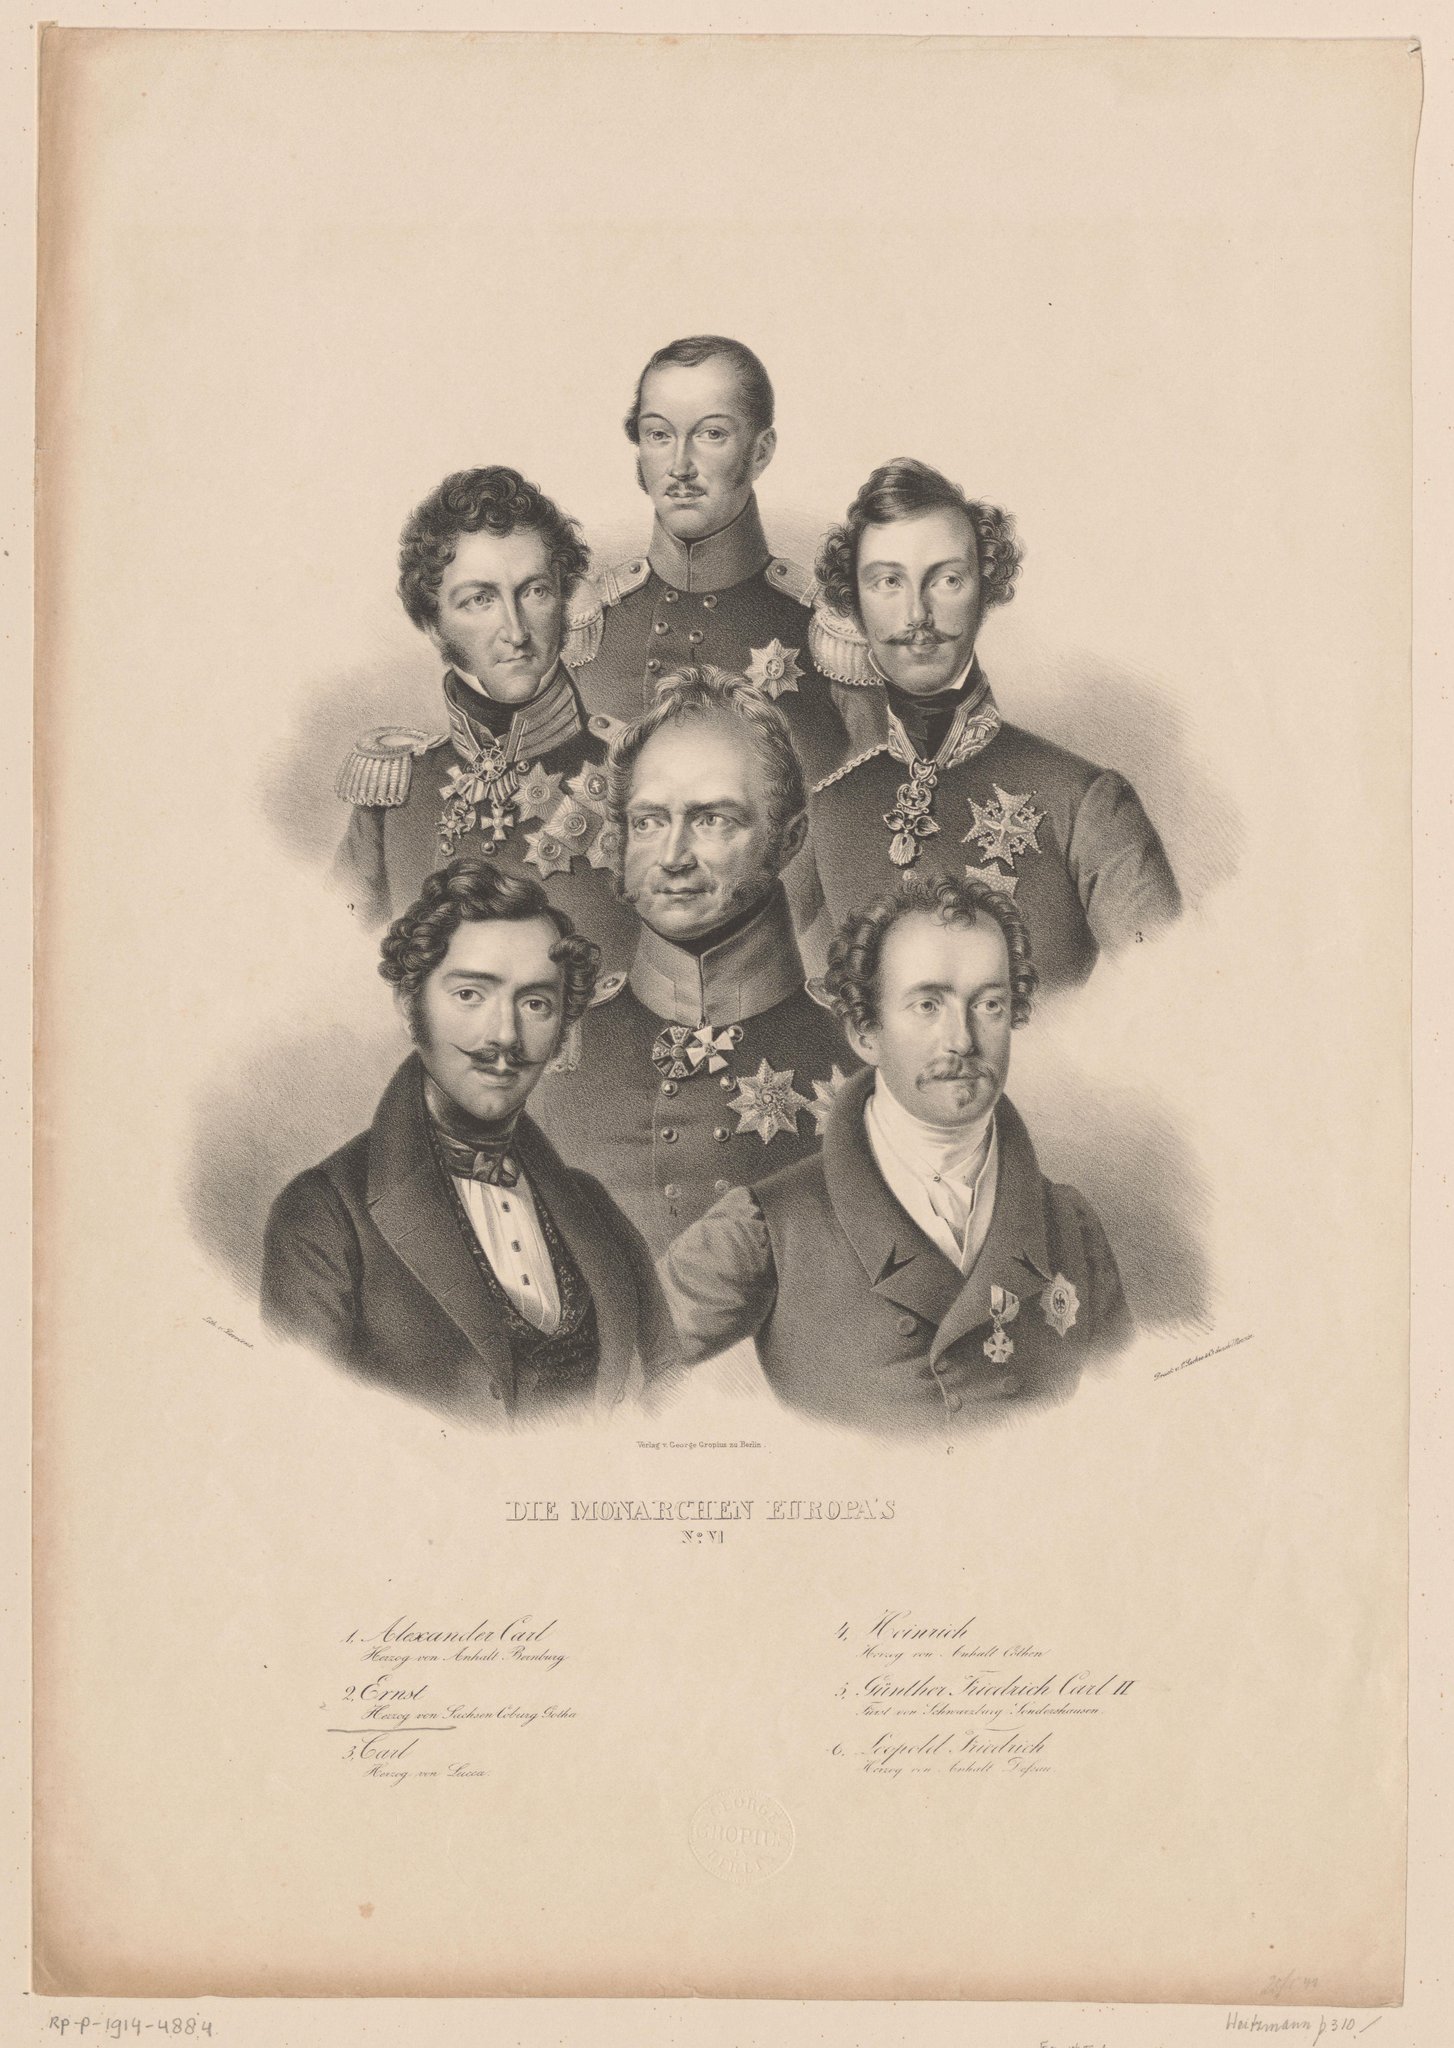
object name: print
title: Europese vorsten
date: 1834-1842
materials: paper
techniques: lithograph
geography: berlin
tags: prince, historical persons, king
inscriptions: check stamp: Lugt 4221, collector's mark: Lugt 2228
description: De portretten zijn genummerd 1 t/m 6. Portretten van Alexander Karl von Anhalt-Bernburg, Ernst I van Saksen-Coburg en Gotha, Karel Lodewijk Ferdinand van Bourbon-Parma, Hendrik van Anhalt-Köthen, Günther Friedrich Karl II. von Schwarzburg-Sondershausen, en van Leopold IV Friedrich Herzog von Anhalt-Dessau. Genummerd: No. VI.